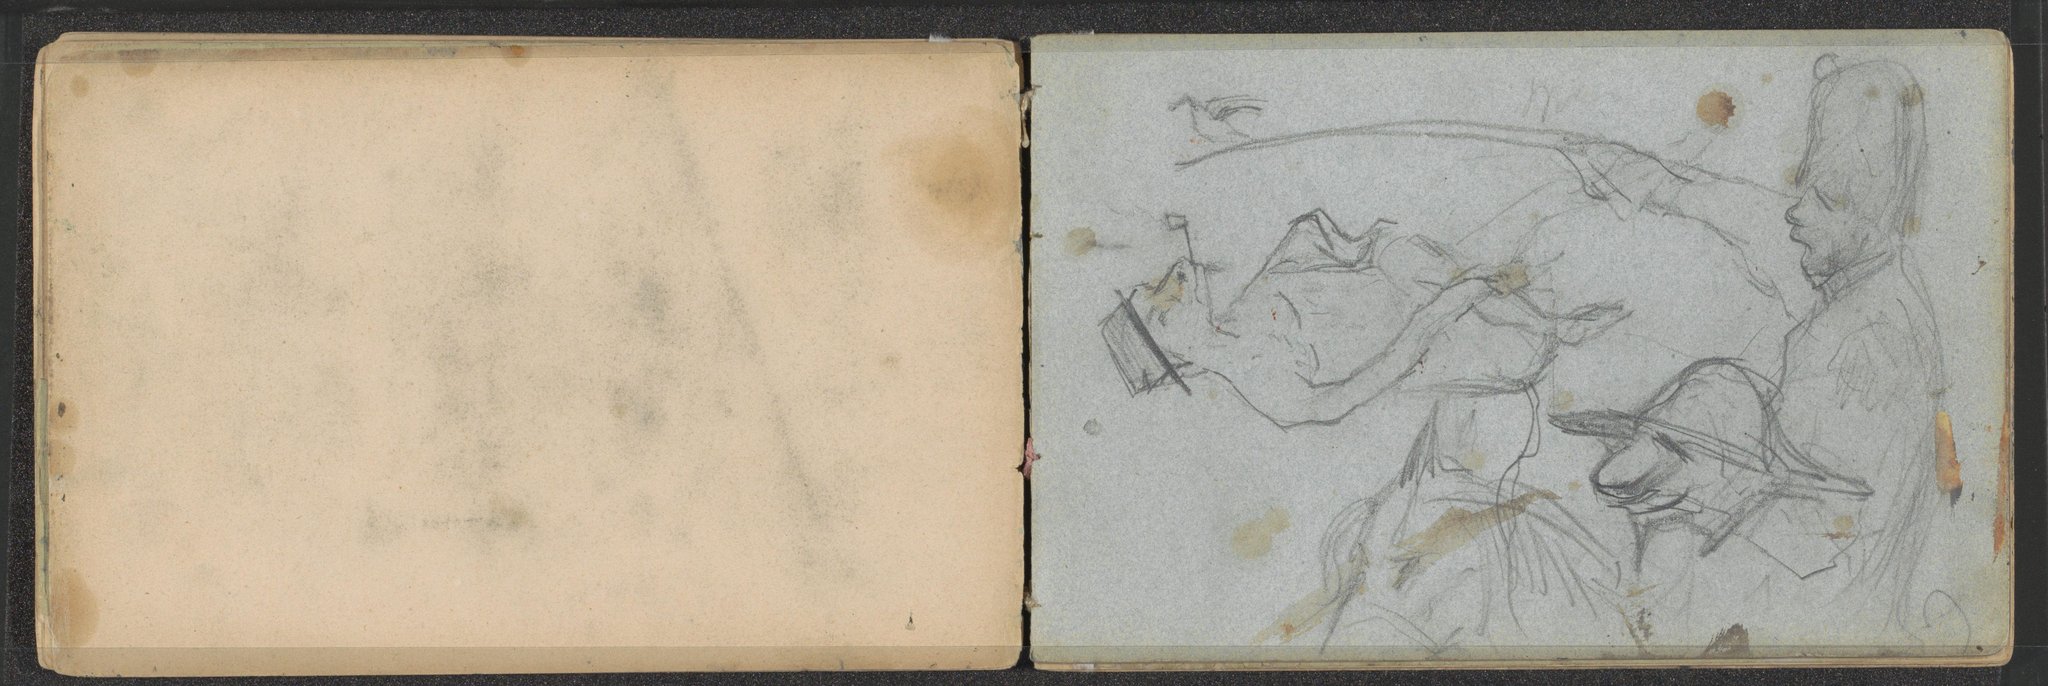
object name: sketchbook leaf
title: Studieblad met figuren en dieren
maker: louis apol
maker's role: draughtsman, painter, print maker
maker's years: 1850-1936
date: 1880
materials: paper, pencil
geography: barentsz sea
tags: monkeys, apes, birds, adult man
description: Blad 17 recto uit een schetsboek met 35 bladen betekend tijdens de expeditie naar Nova Zembla in 1880.